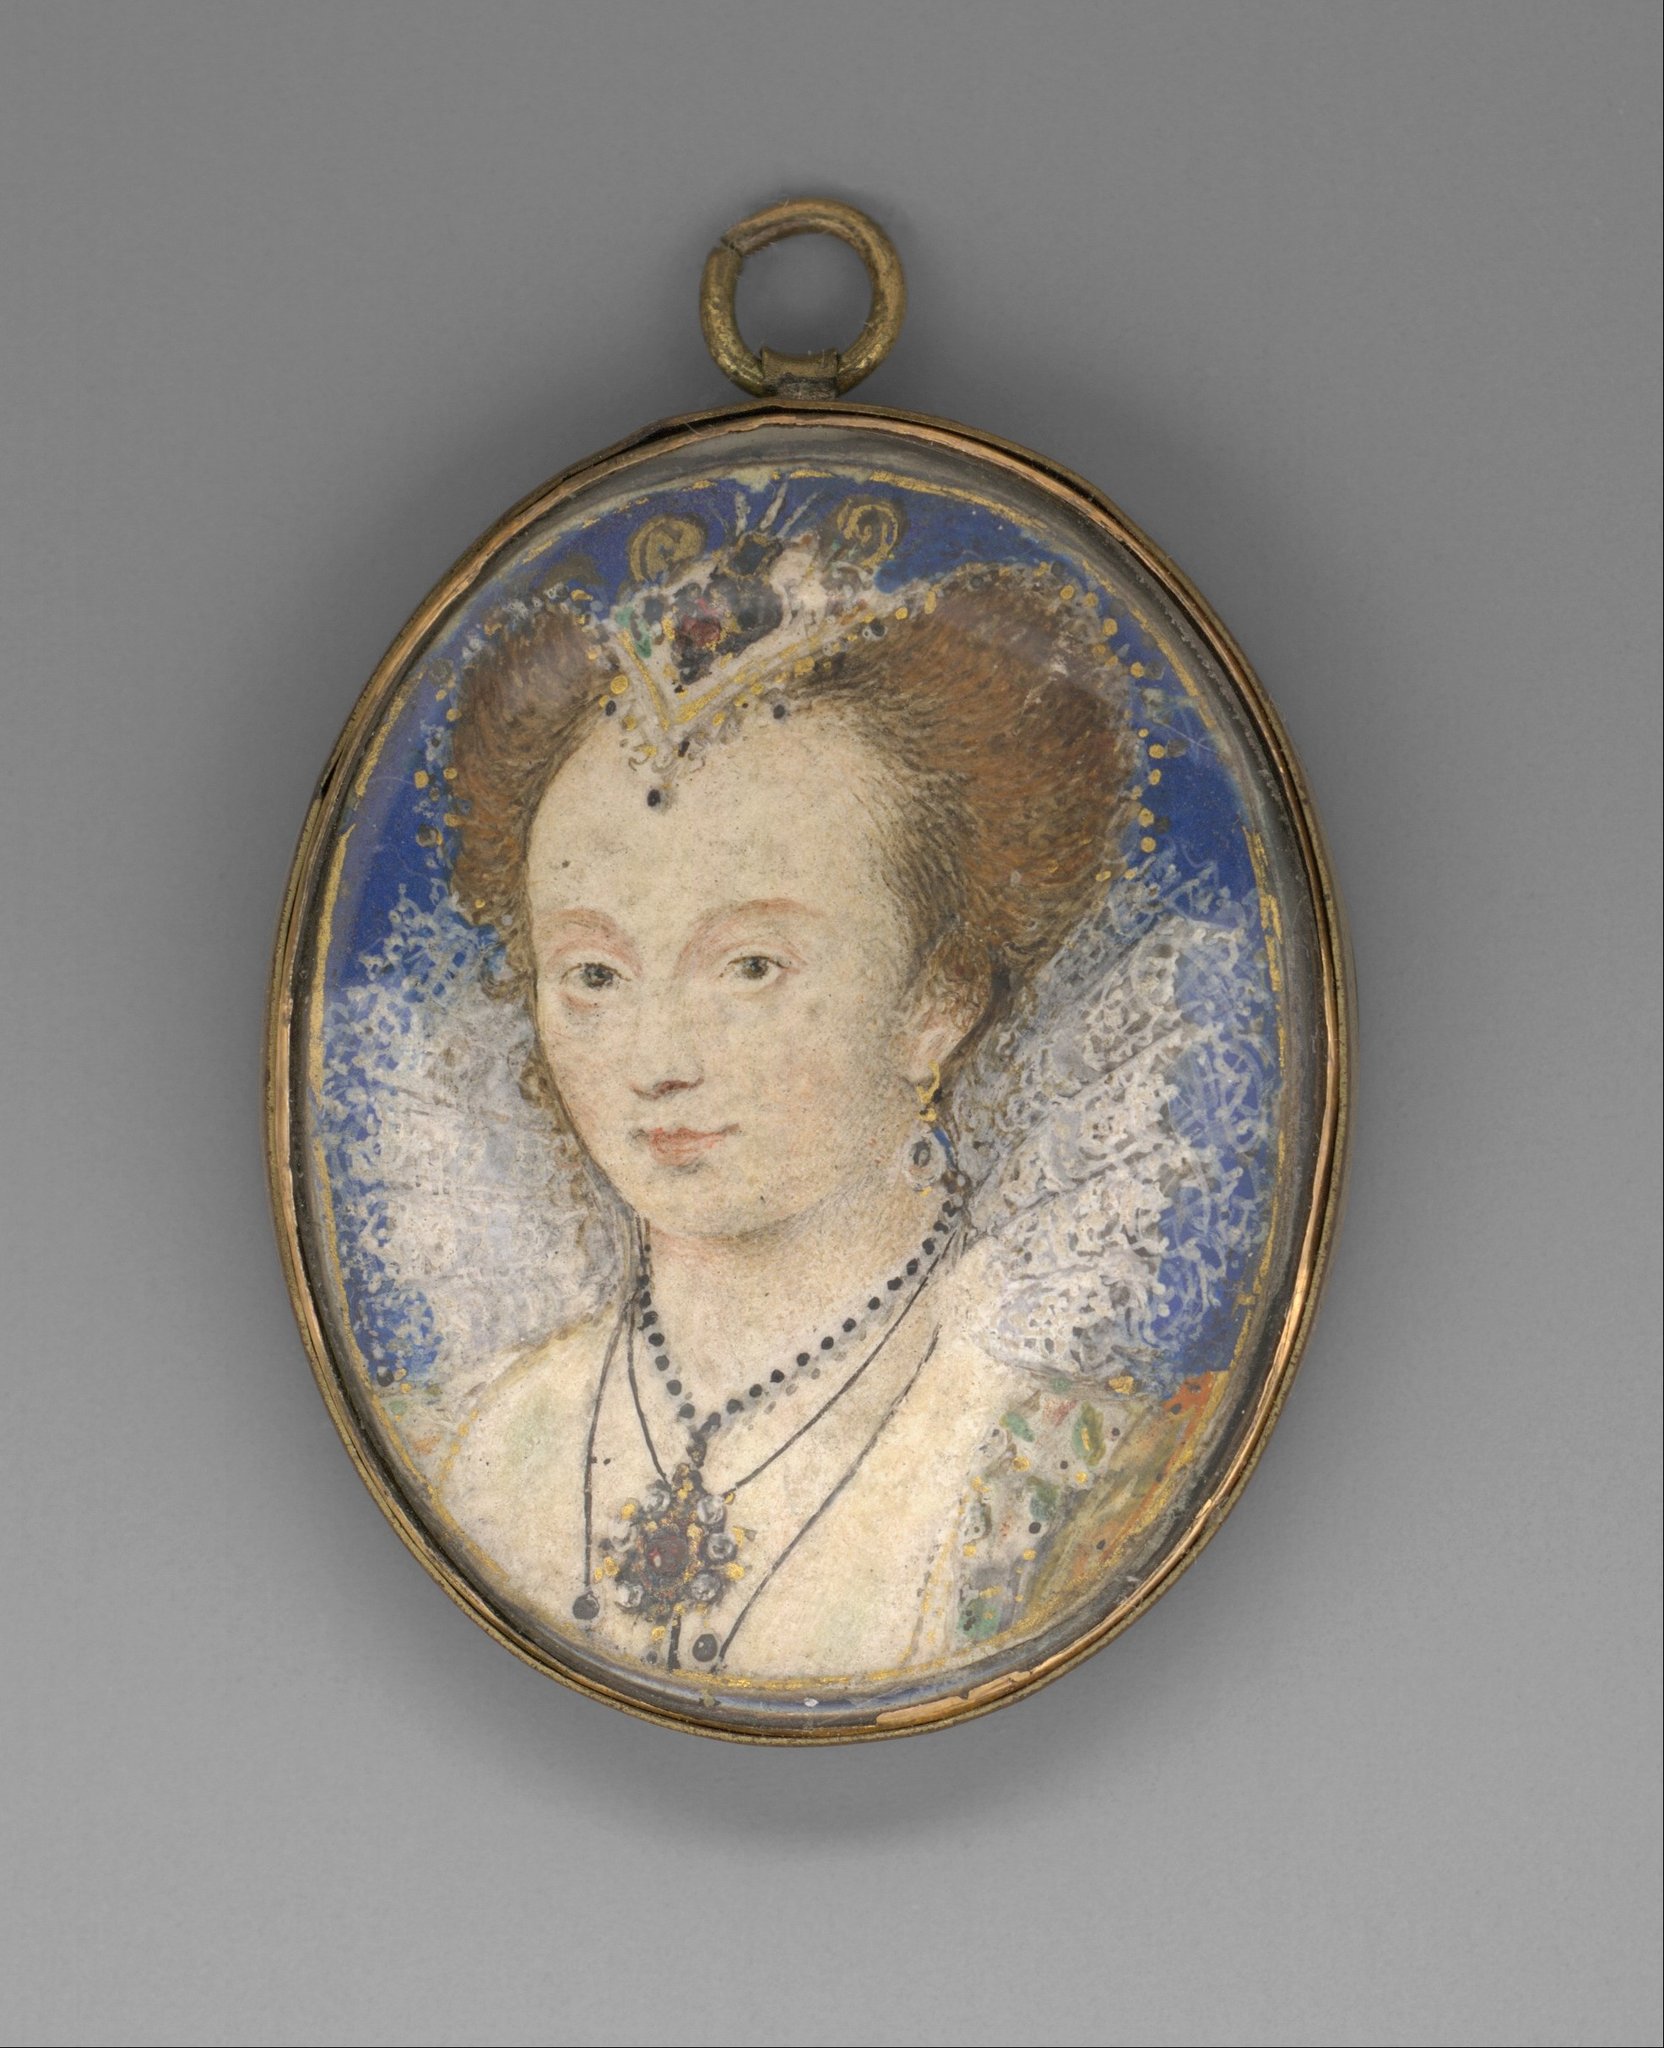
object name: painting, miniature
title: Portrait of a Woman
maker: nicholas hilliard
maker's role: artist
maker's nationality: british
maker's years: 1542-1619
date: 1590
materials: parchment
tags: portraits,women